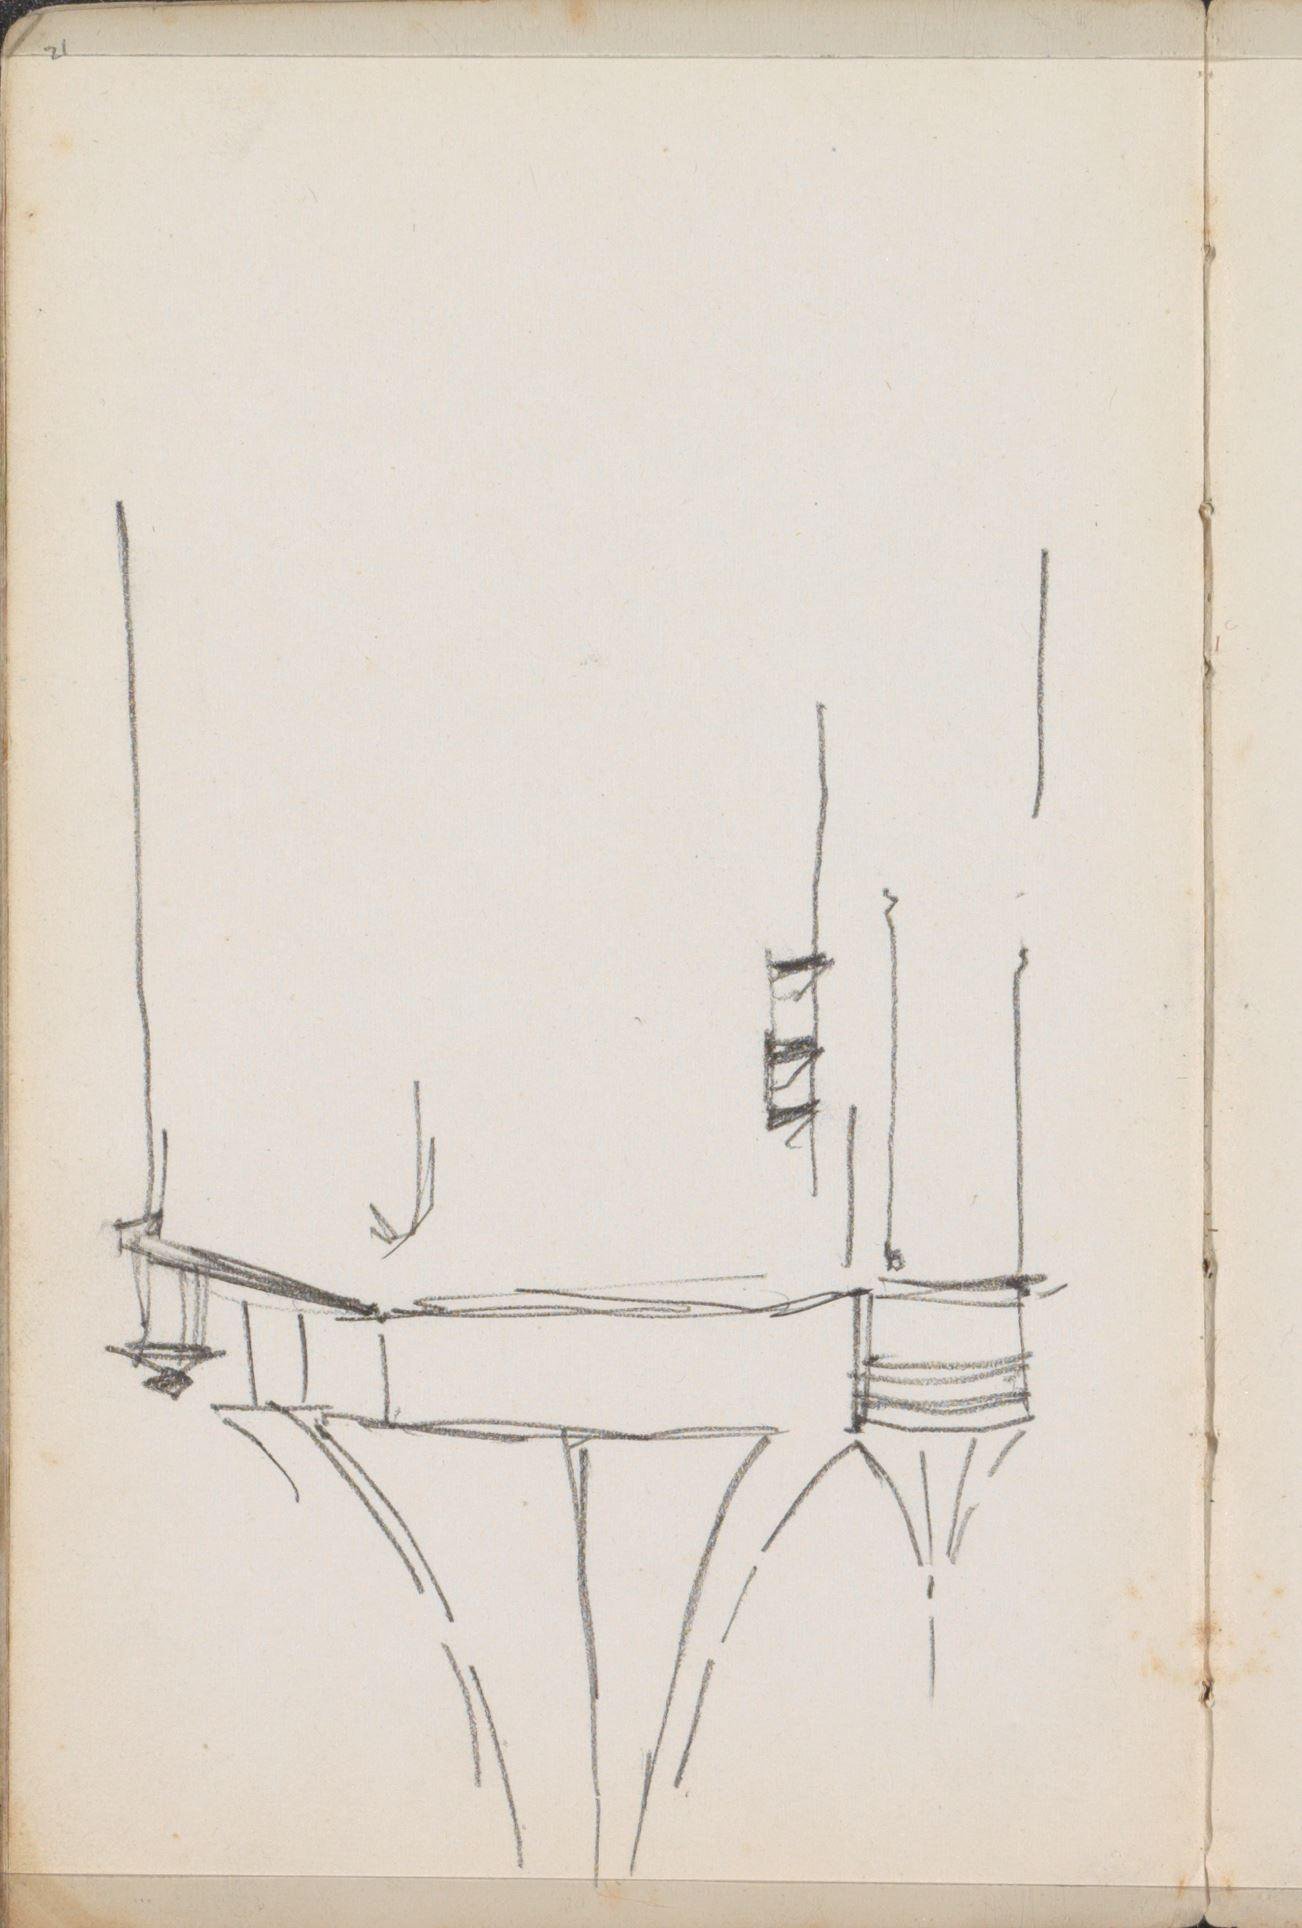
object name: sketchbook leaf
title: Toren, mogelijk de toren van de Grote Kerk te Gorinchem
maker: george hendrik breitner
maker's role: draughtsman, painter, print maker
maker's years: 1857-1923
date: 1880-1882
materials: chalk, paper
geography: gorinchem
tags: parts of church exterior and annexes: tower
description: Pagina 21 uit een schetsboek met 72 bladen.